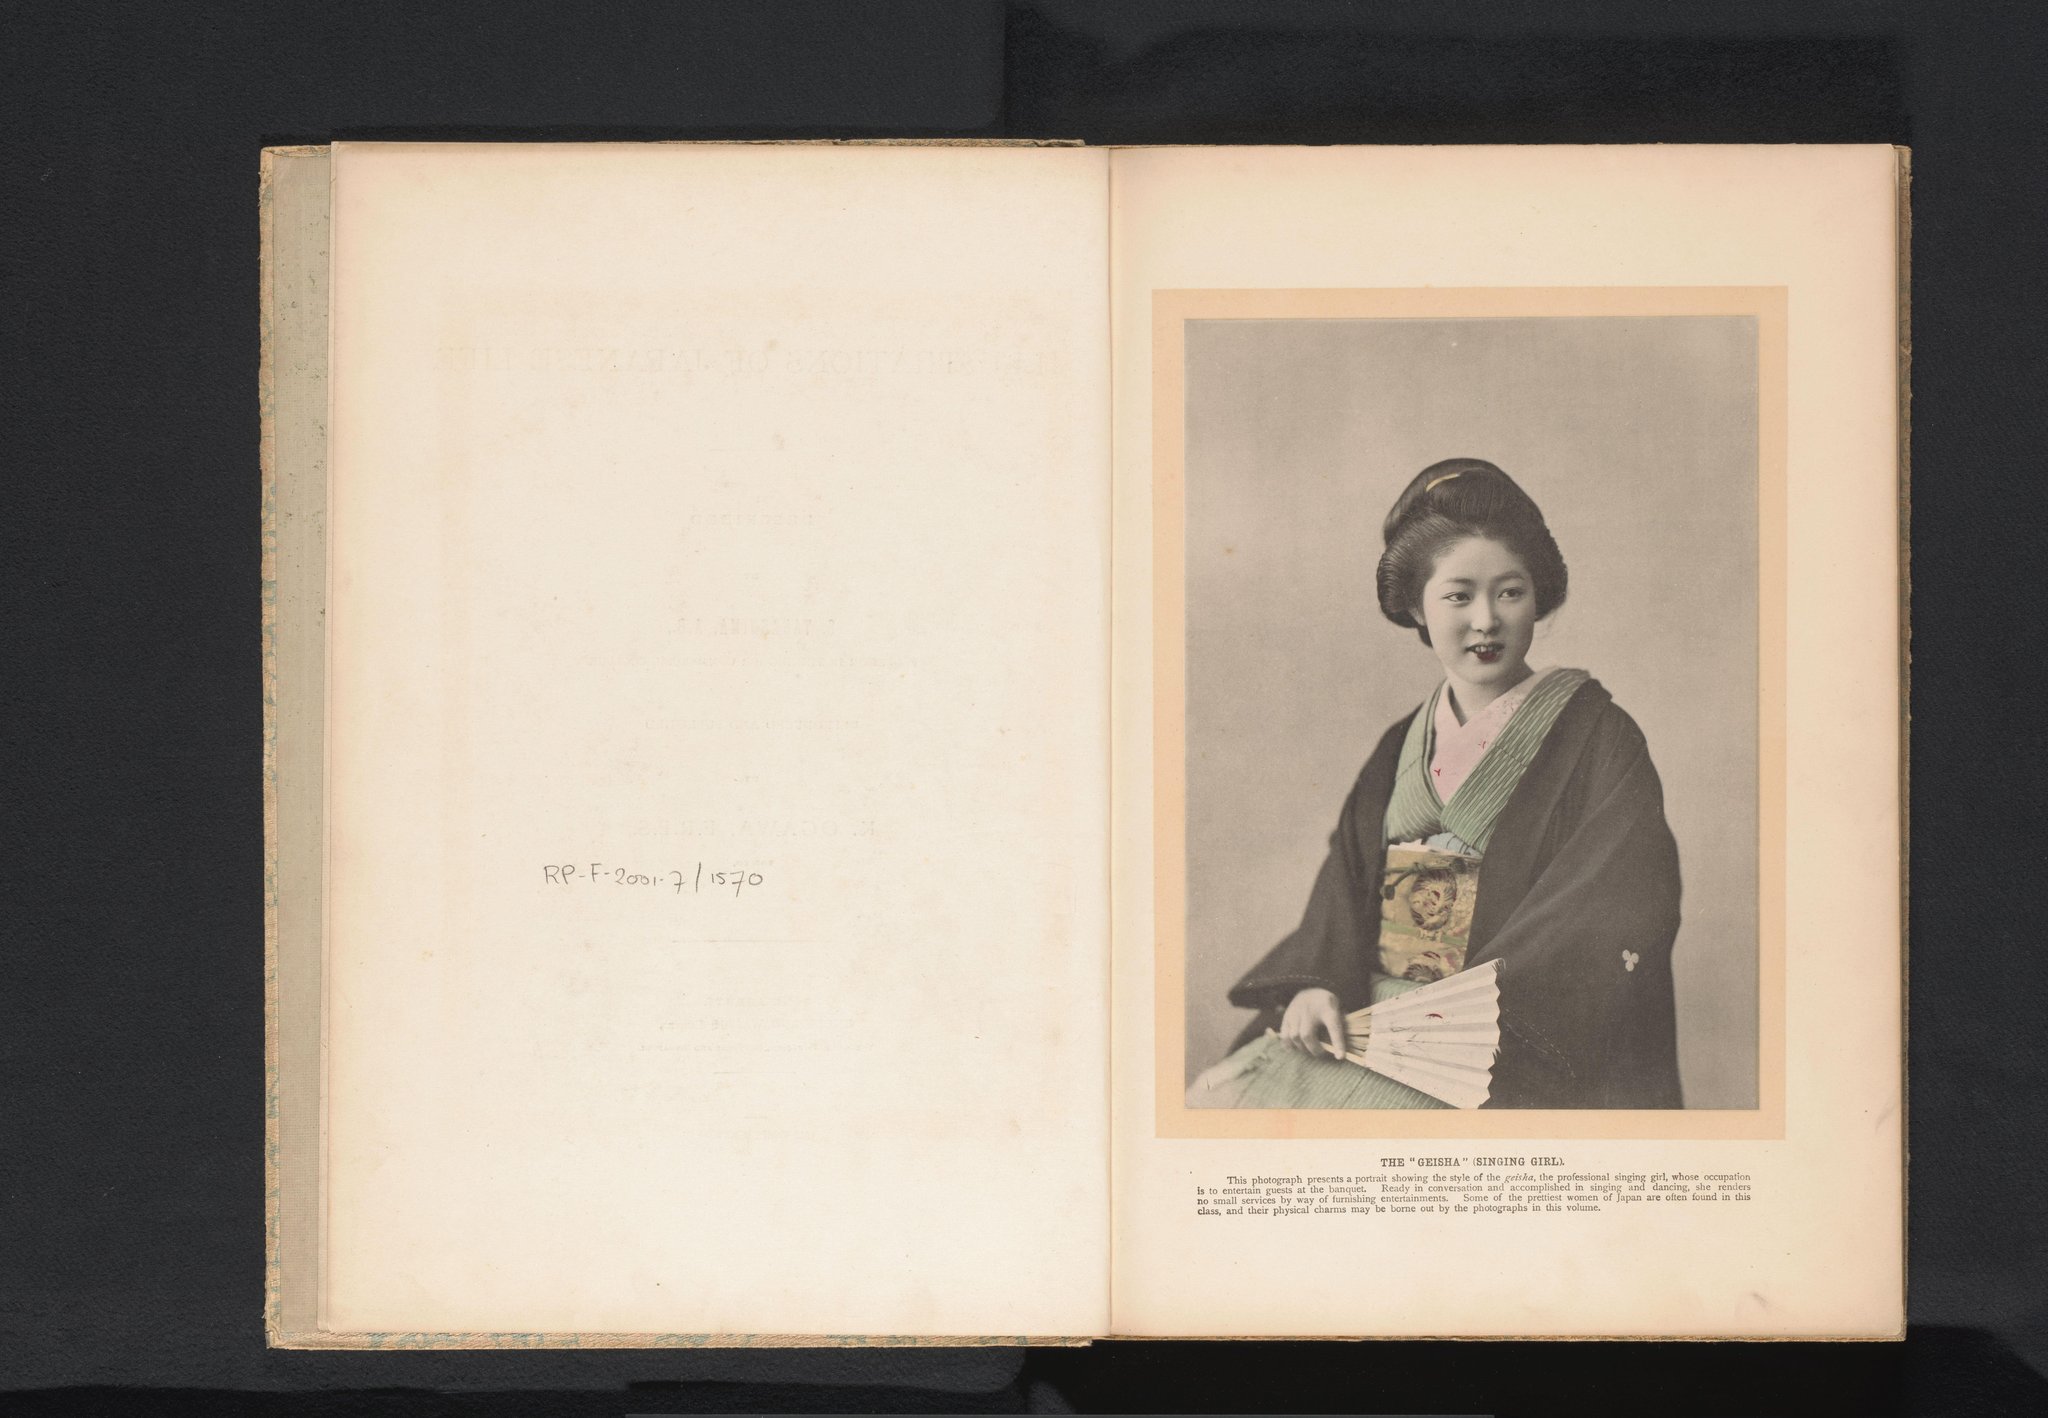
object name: photomechanical print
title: Portret van een onbekende geisha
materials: paper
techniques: photograph, lithograph, hand coloring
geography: tokyo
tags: historical persons not known by name - bb - woman, courtesan, hetaera, japan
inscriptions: inscription: ‘This photograph (...) this volume.’